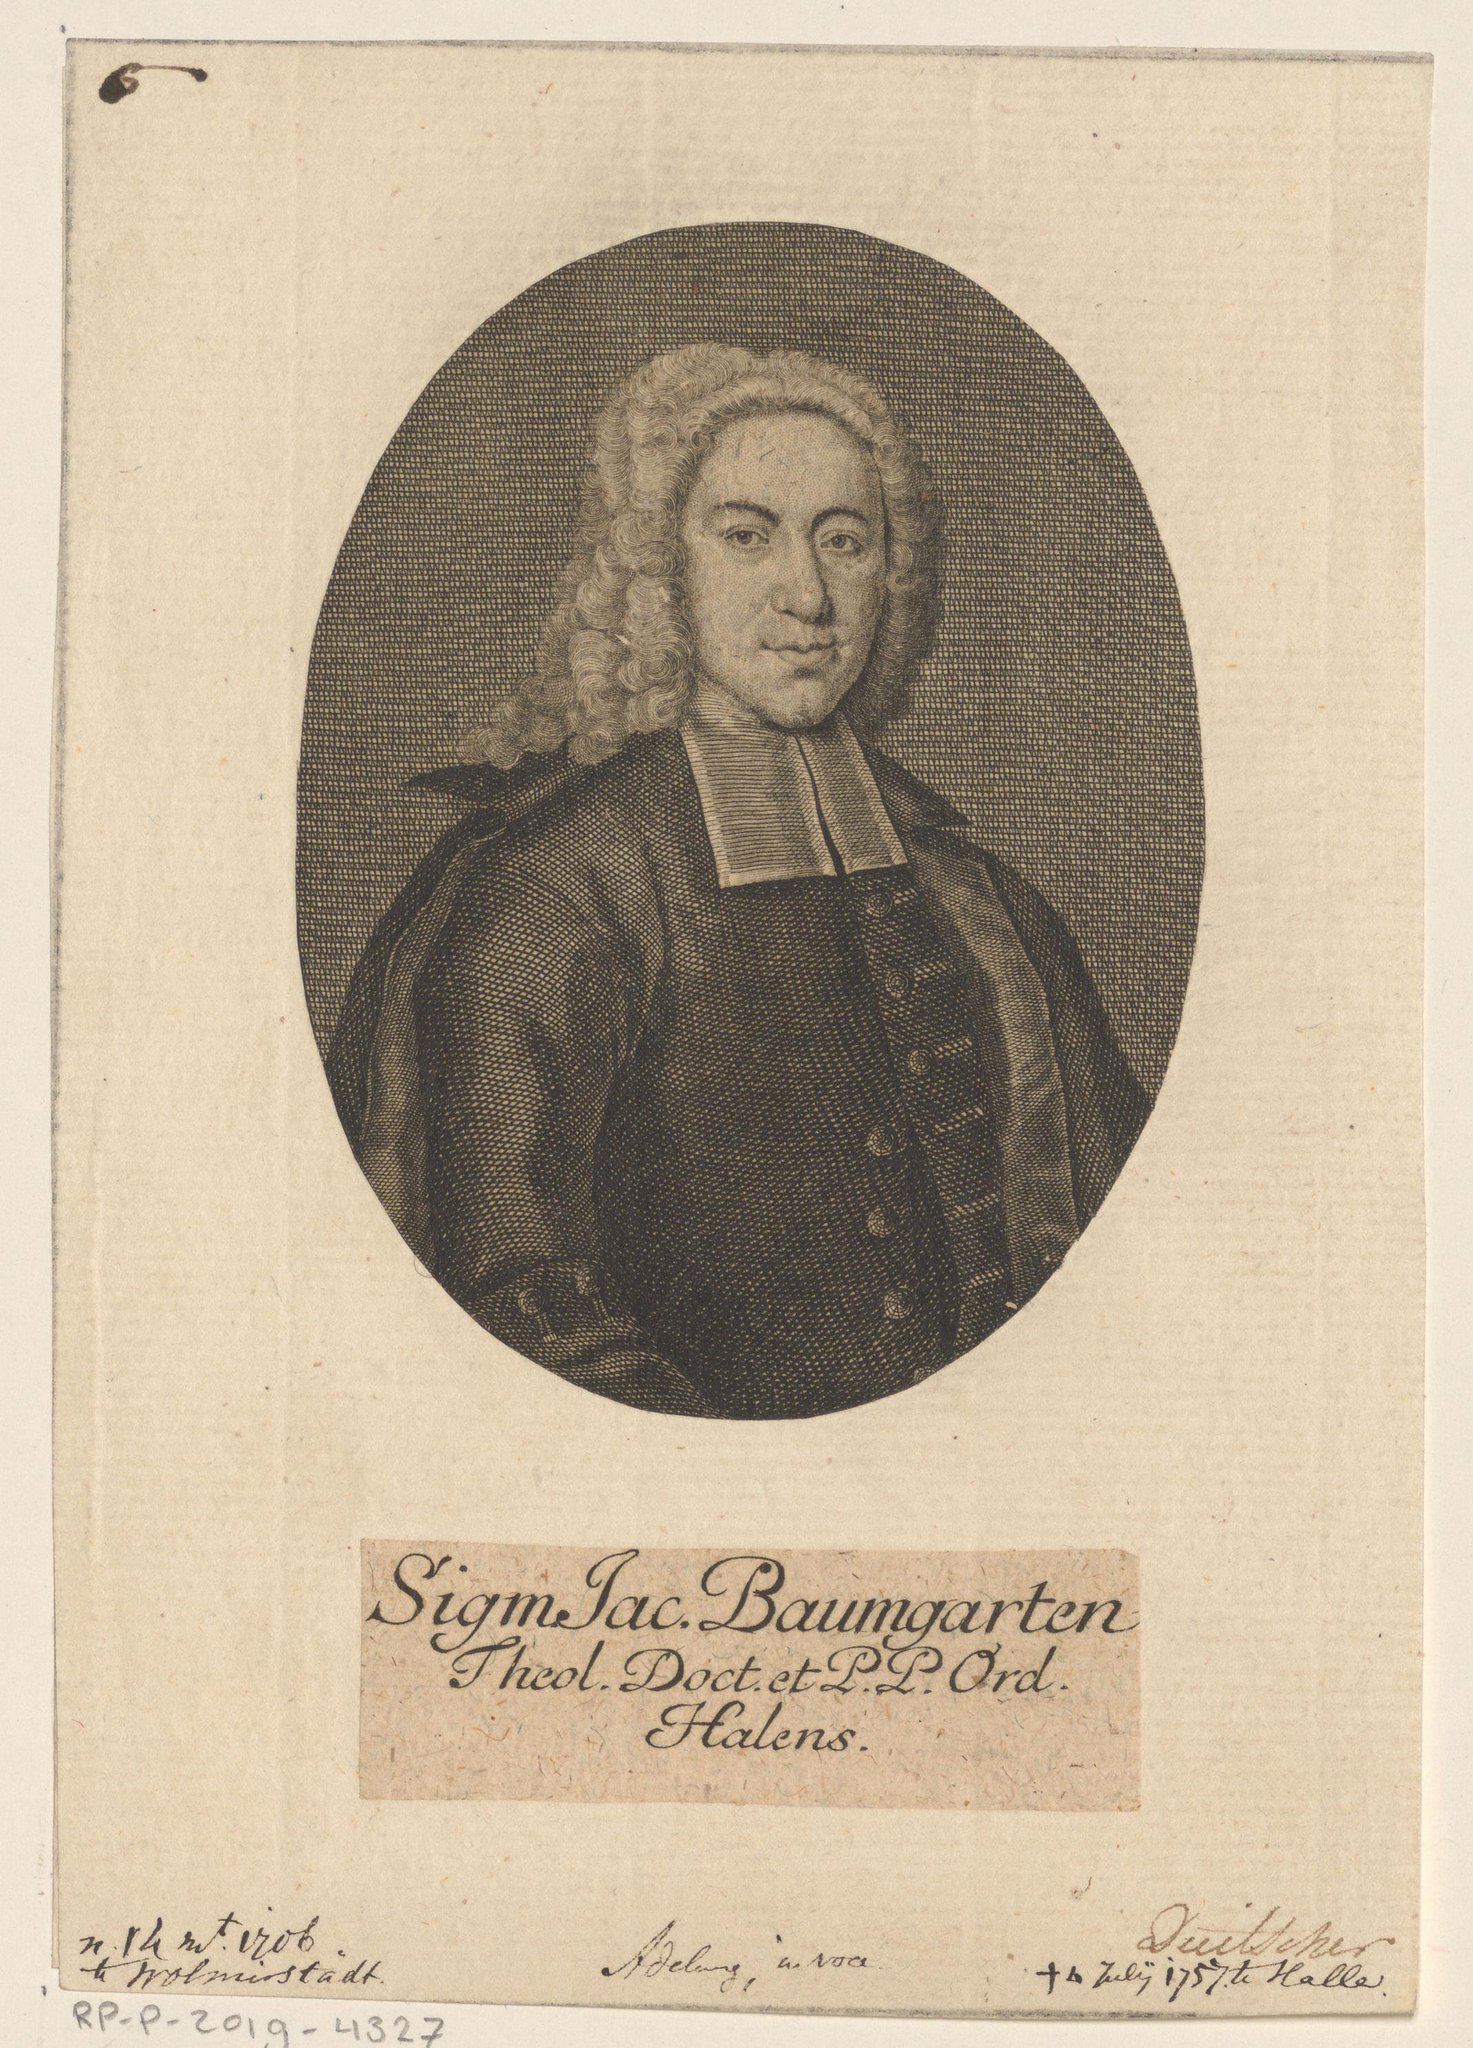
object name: book illustration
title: Portret van Sigmund Jacob Baumgarten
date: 1740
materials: paper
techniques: engraving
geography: leipzig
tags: historical persons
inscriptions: inscription: ‘n. 14 mt 1706 te Wolmirstädt [...]’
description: Prent uit: Zuverläßige Nachrichten von dem gegenwärtigen Zustande, Veränderung und Wachsthum der Wissenschaften. Leipzig: Johann Friedrich Gleditsch, 1740, dl. 6.